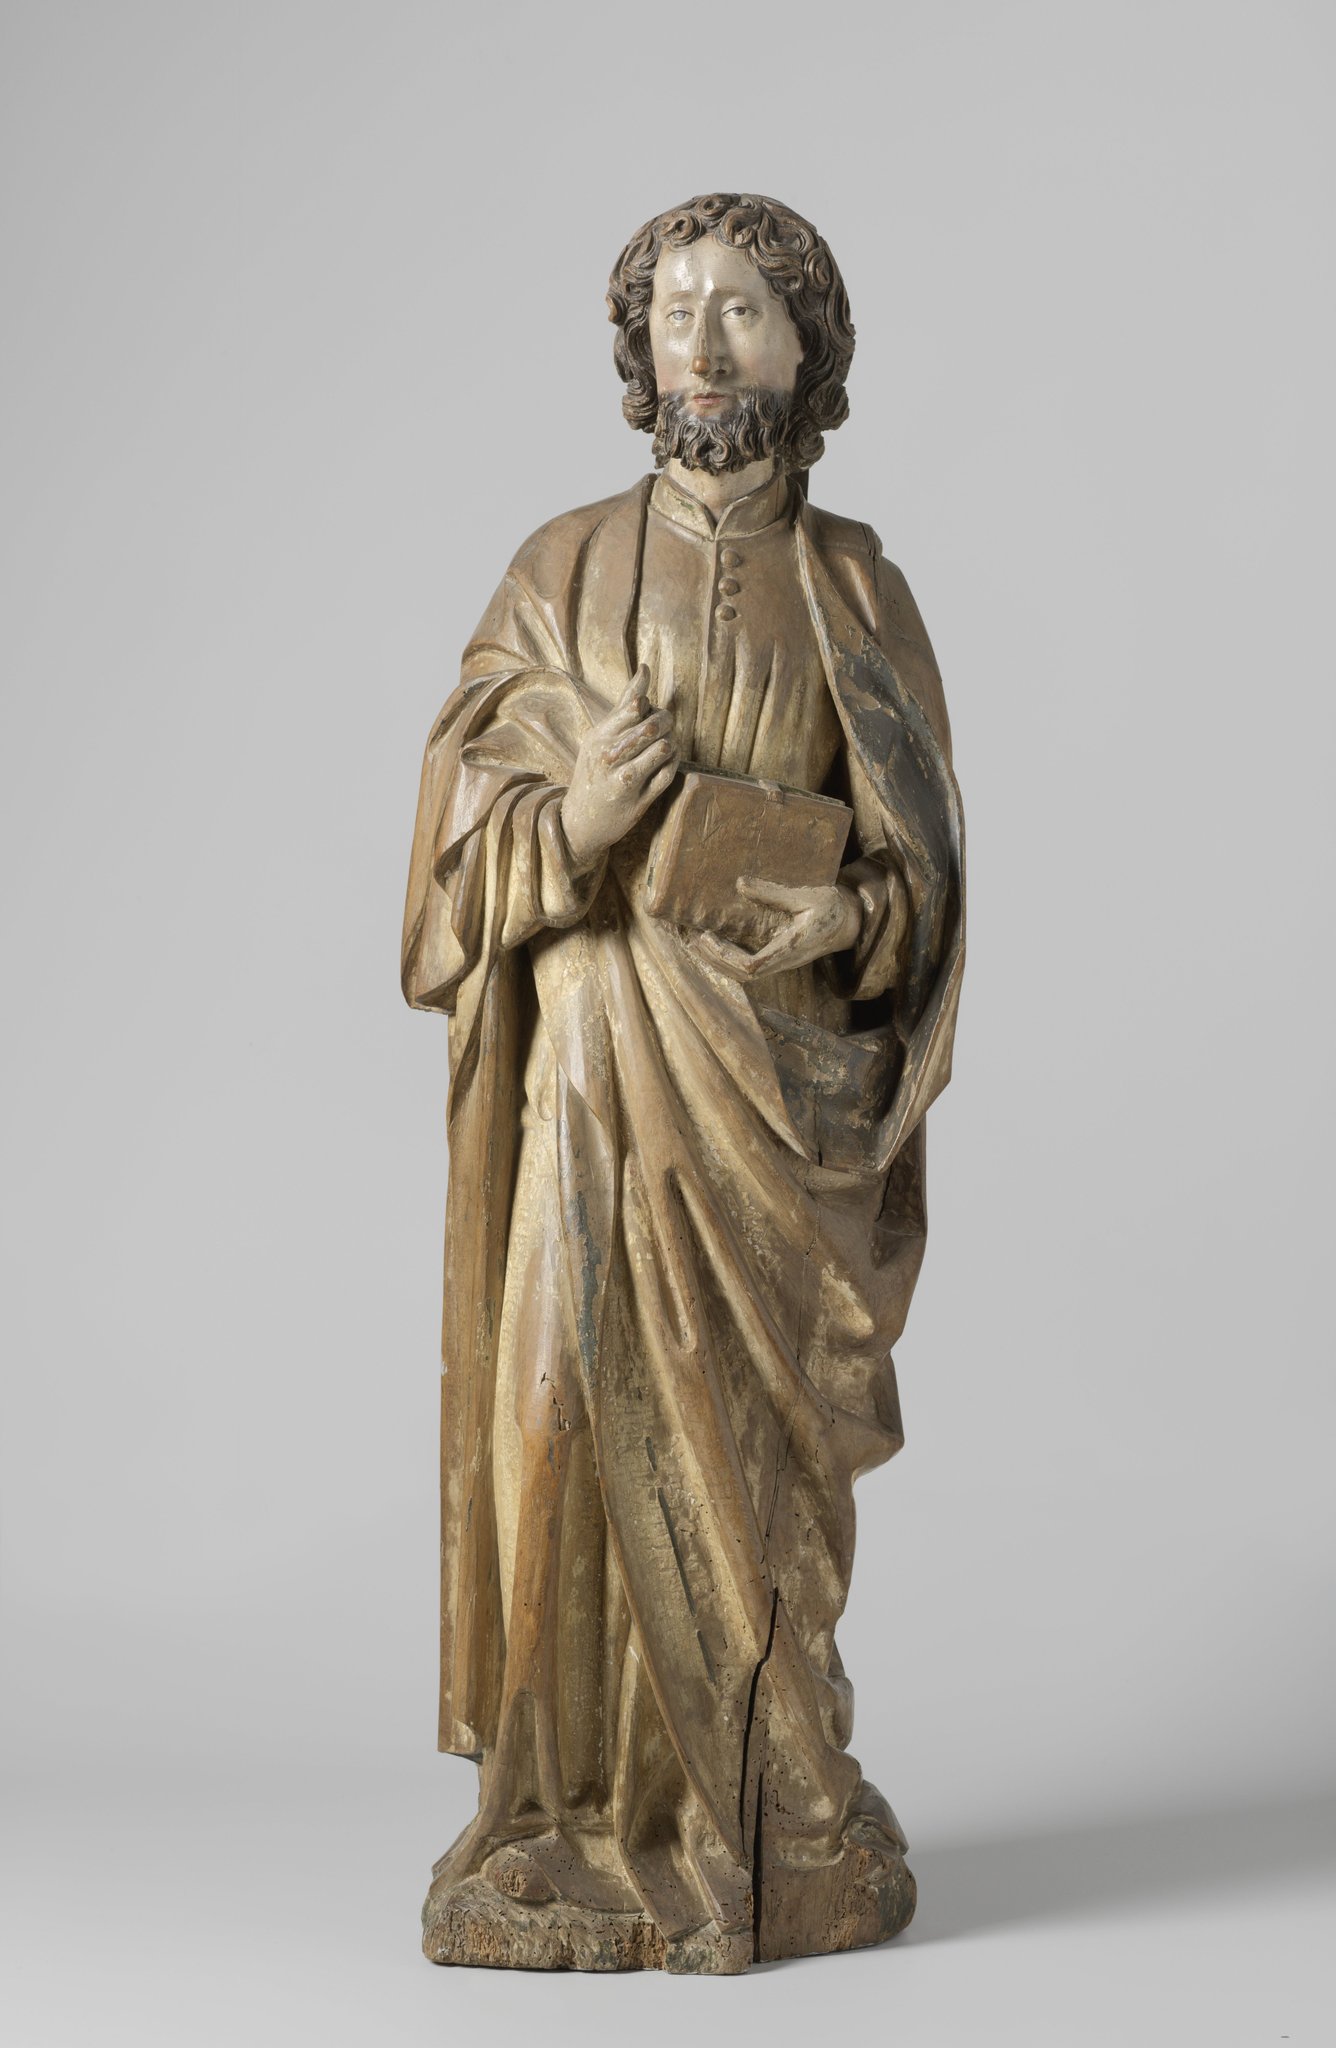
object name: sculpture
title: St James the Less (?)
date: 1470-1500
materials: wood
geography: north brabant